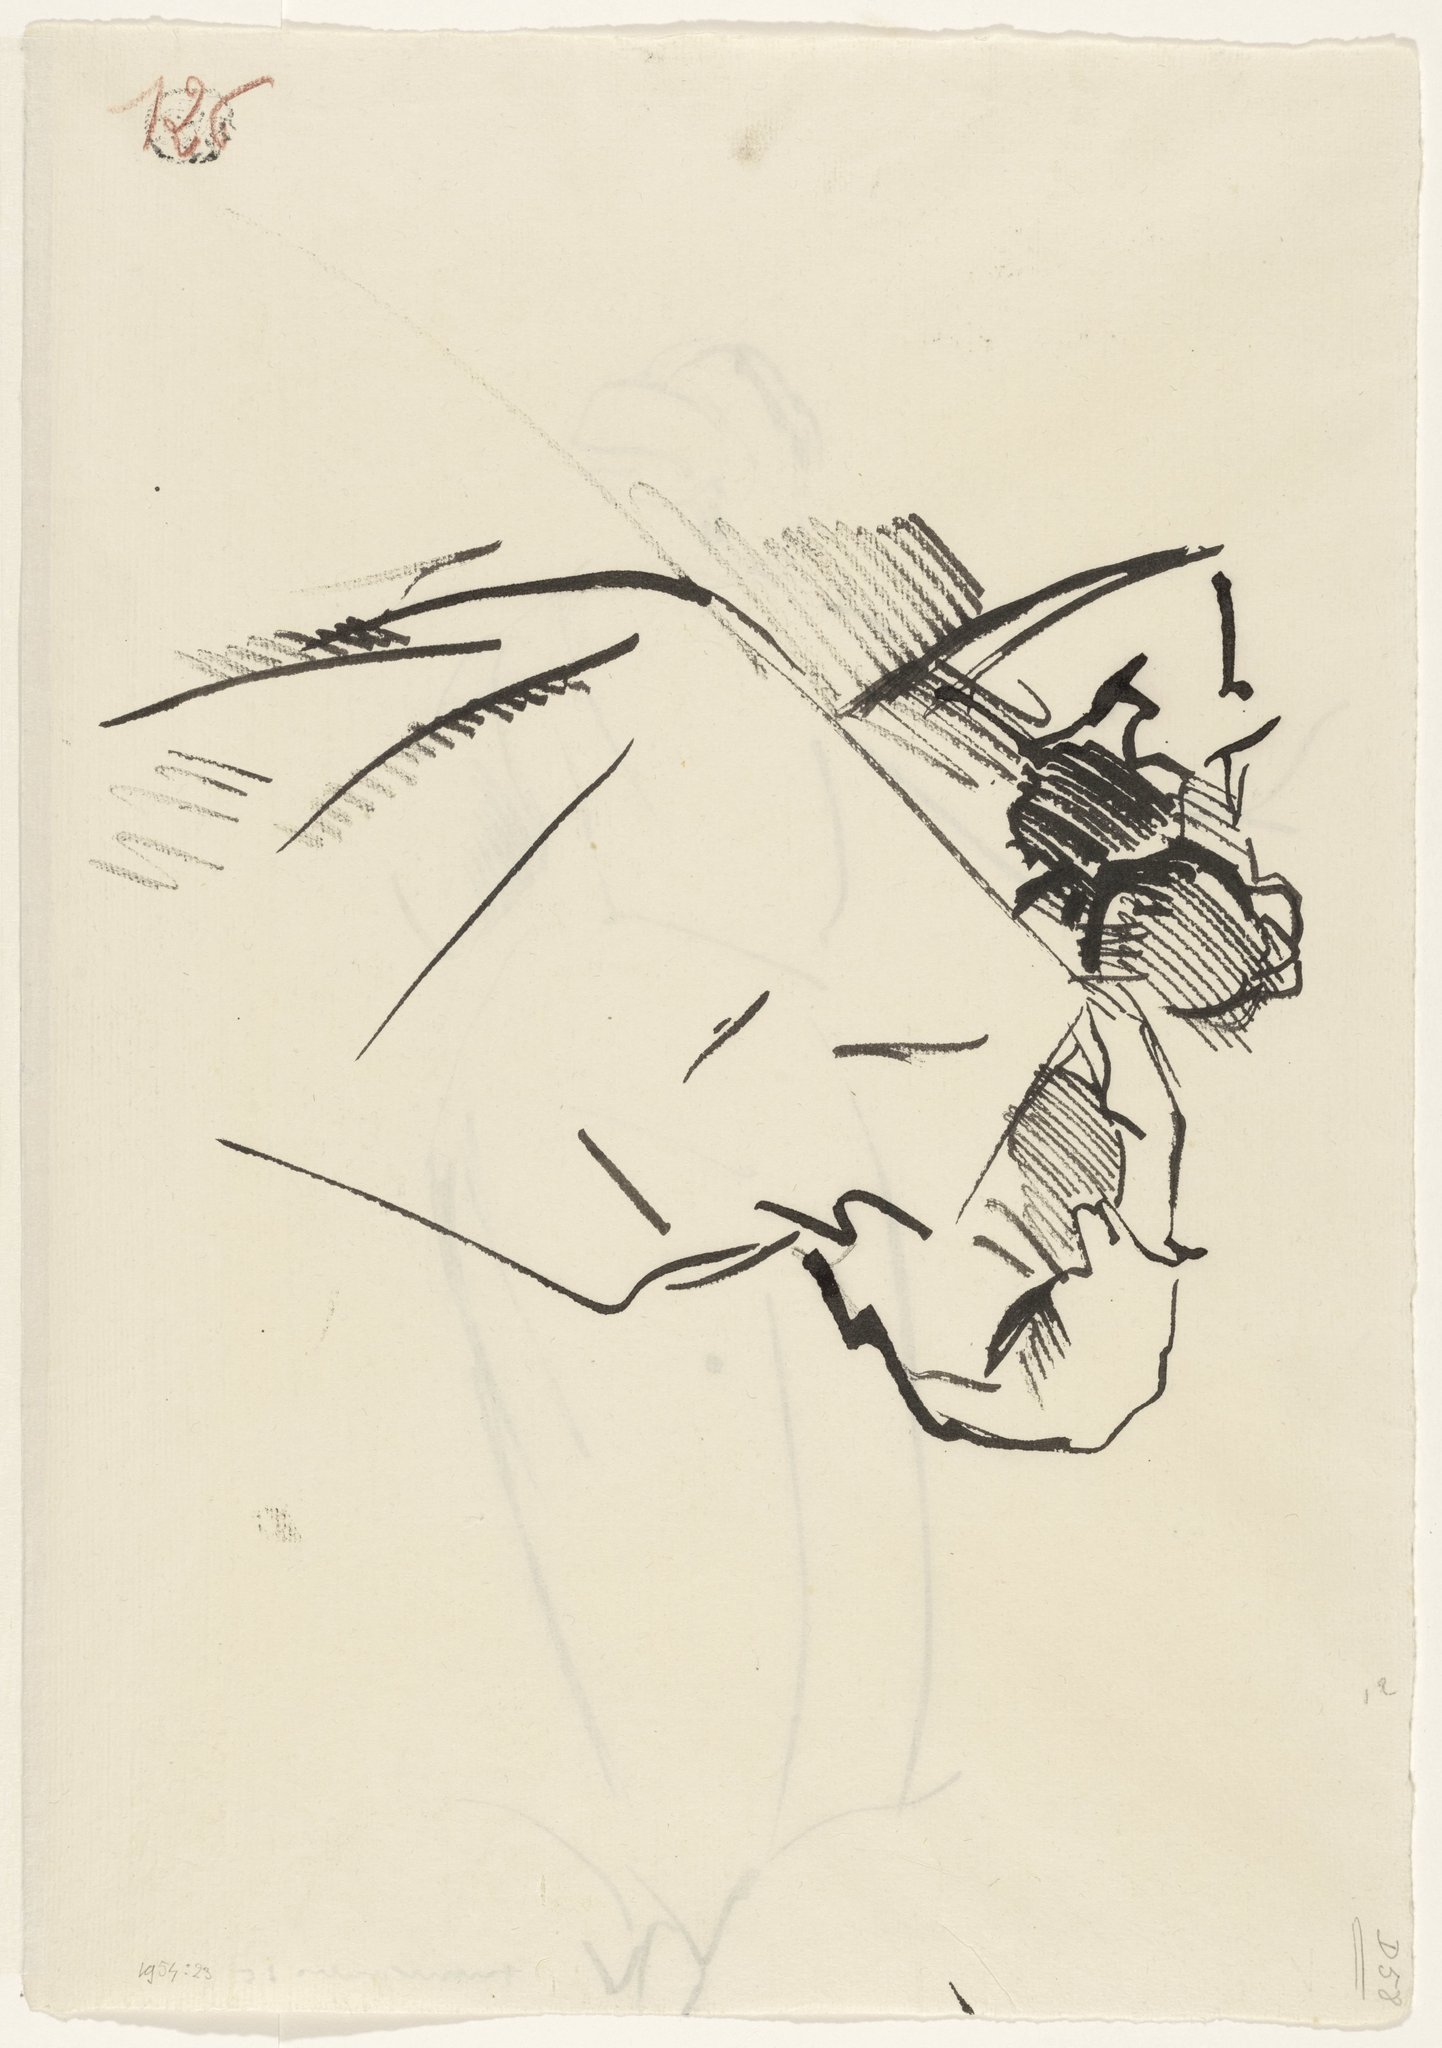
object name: drawing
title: Zich kappende vrouw, op de rug gezien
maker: rik wouters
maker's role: draughtsman, print maker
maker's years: 1882-1916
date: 1915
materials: ink, paper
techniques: pen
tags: care of the hair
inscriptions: date: ‘'15’